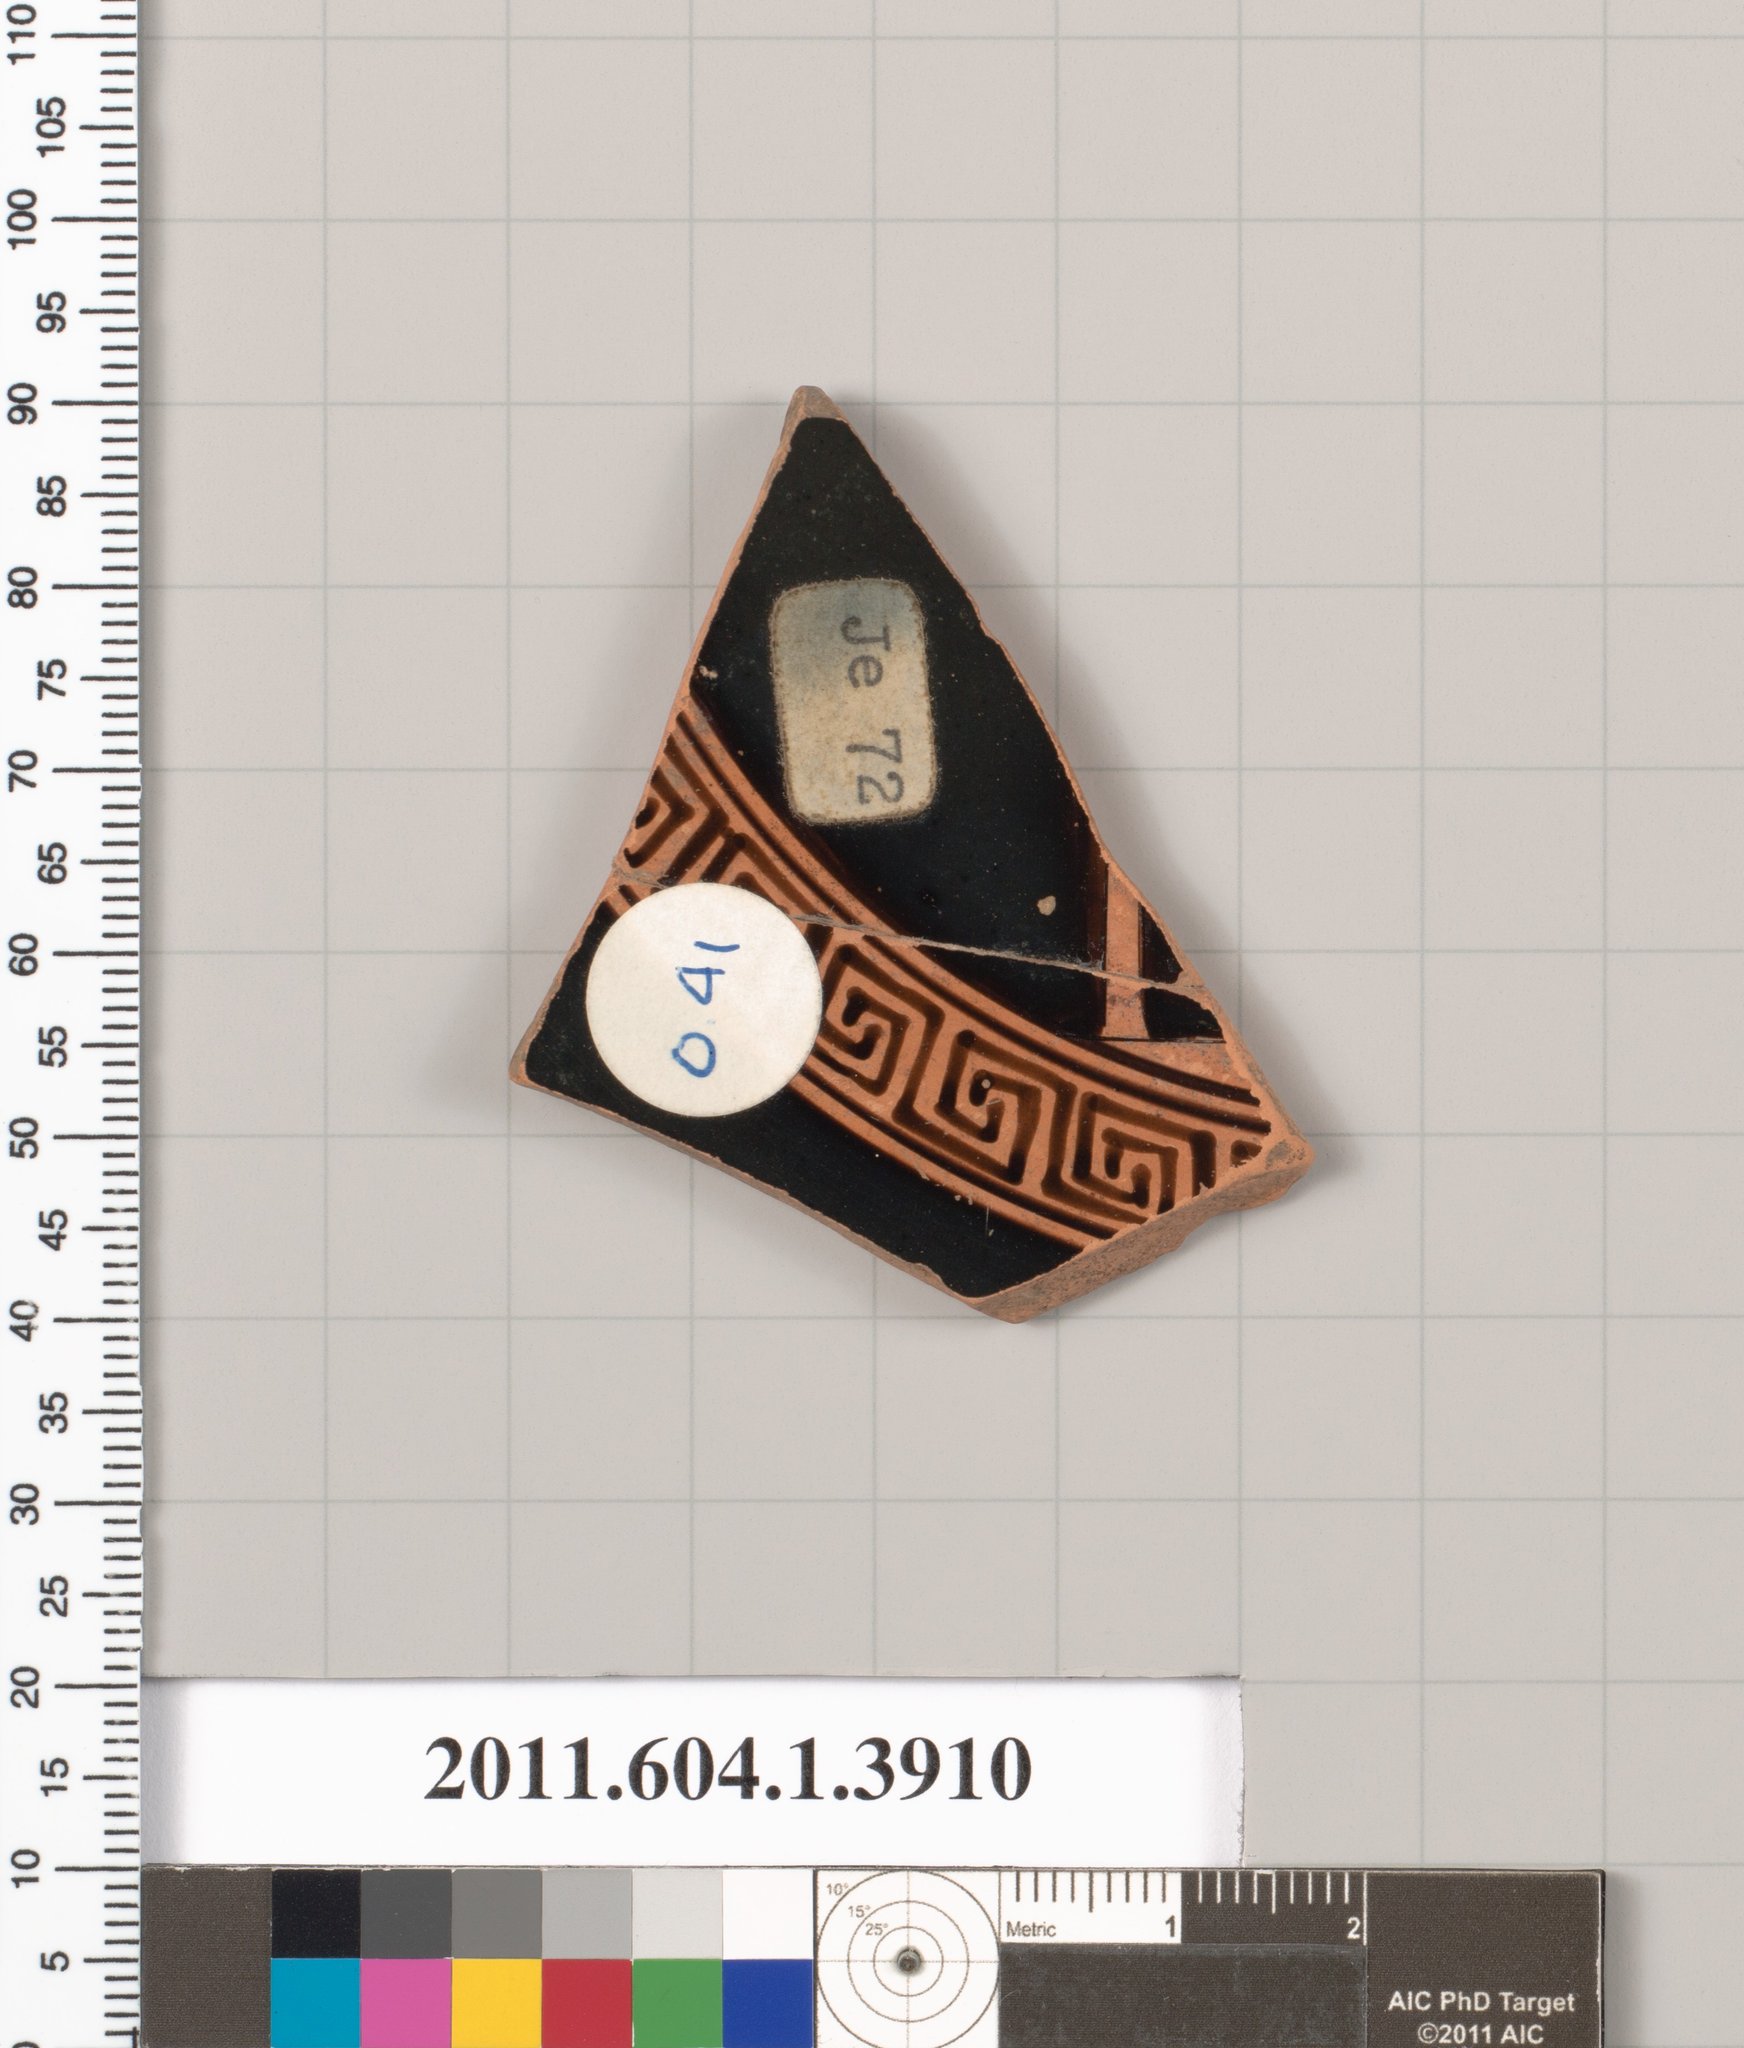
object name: kylix fragment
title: Terracotta fragment of a kylix (drinking cup)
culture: greek, attic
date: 500-480 BCE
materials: terracotta